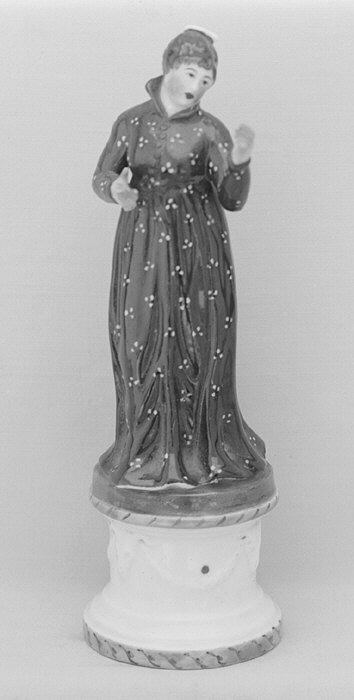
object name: figure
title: Woman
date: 1801-1900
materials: hard paste porcelain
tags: women